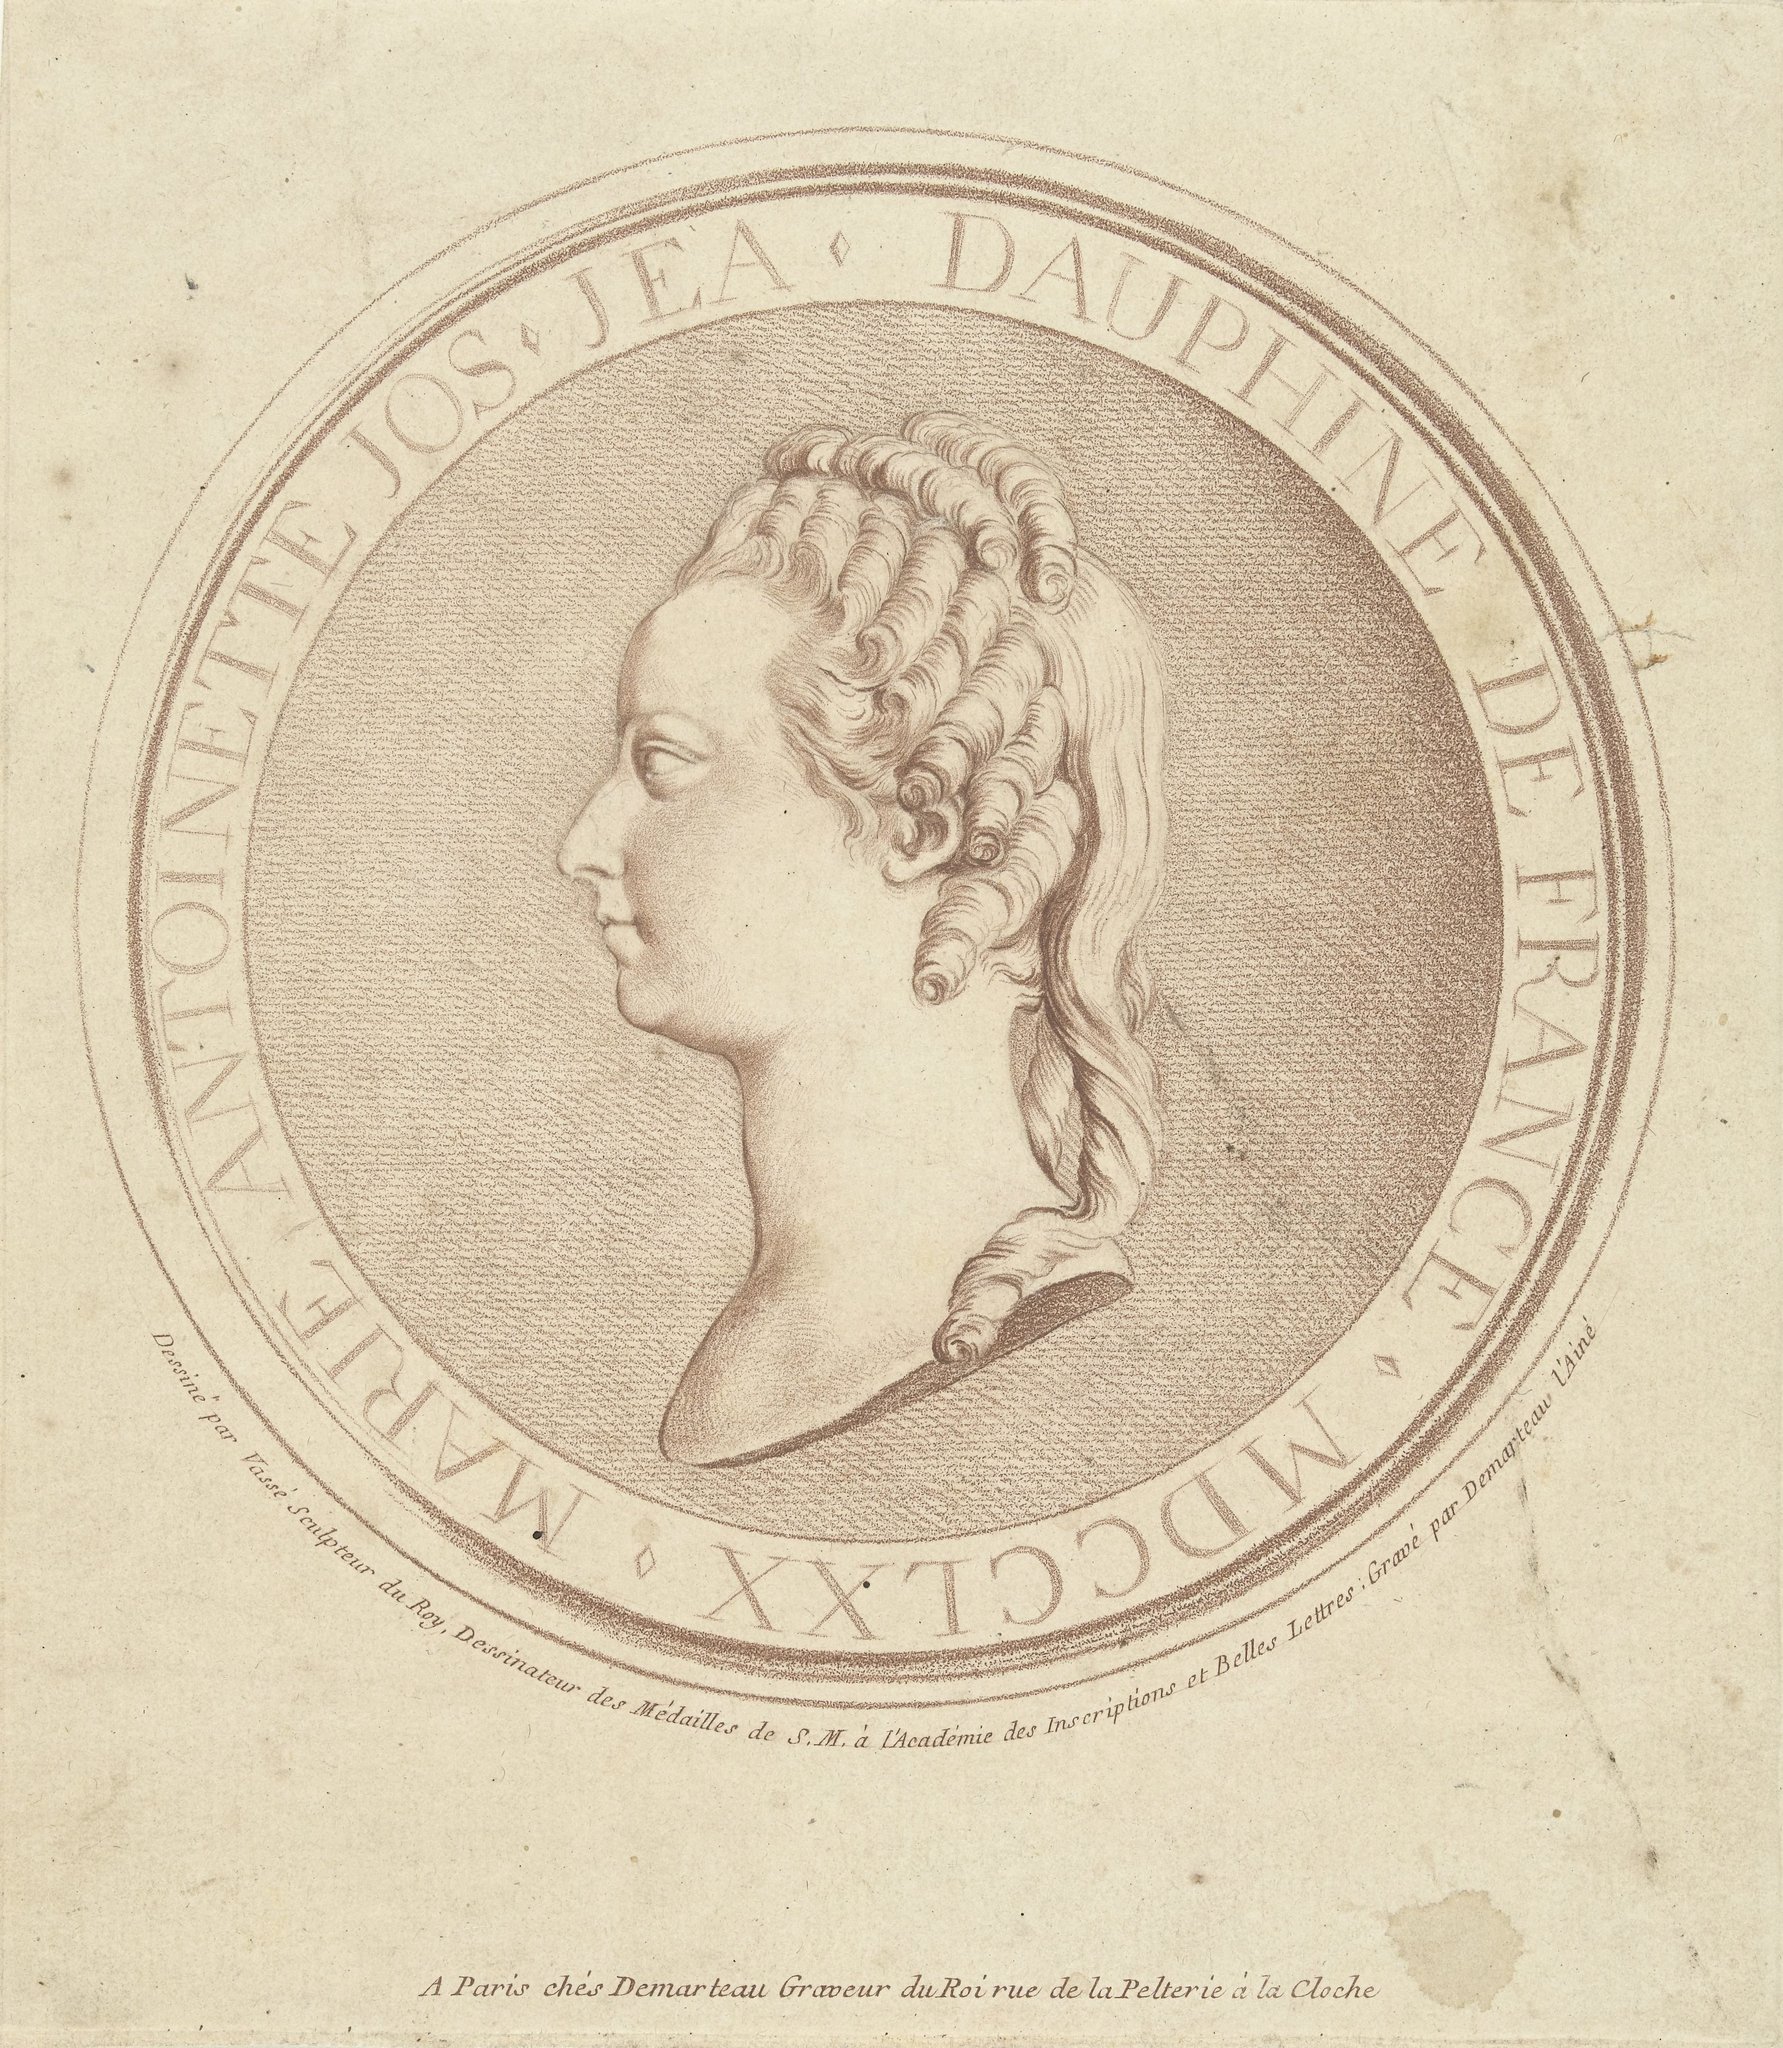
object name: print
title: Portret van Marie Antoinette, Dauphine van Frankrijk, in basreliëf op medaillon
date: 1770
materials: paper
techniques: printmaking, etching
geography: paris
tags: vienna, paris, marie antoinette, memorial medal (+ variant)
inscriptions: collector's mark: Lugt 2228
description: Portret van Marie Antoinette, Dauphine van Frankrijk, borststuk en profil in basreliëf op medaillon met randschrift.